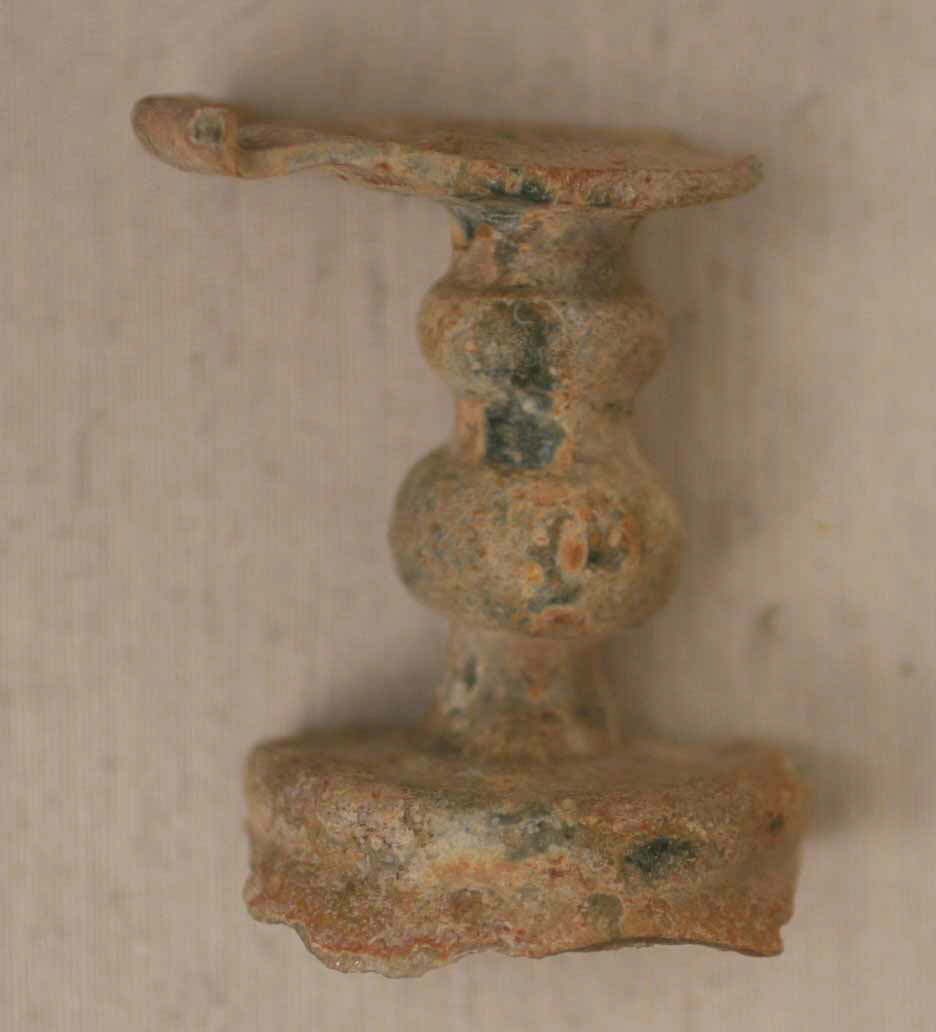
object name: fragment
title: Glass Fragment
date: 801-1100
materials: glass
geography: iraq